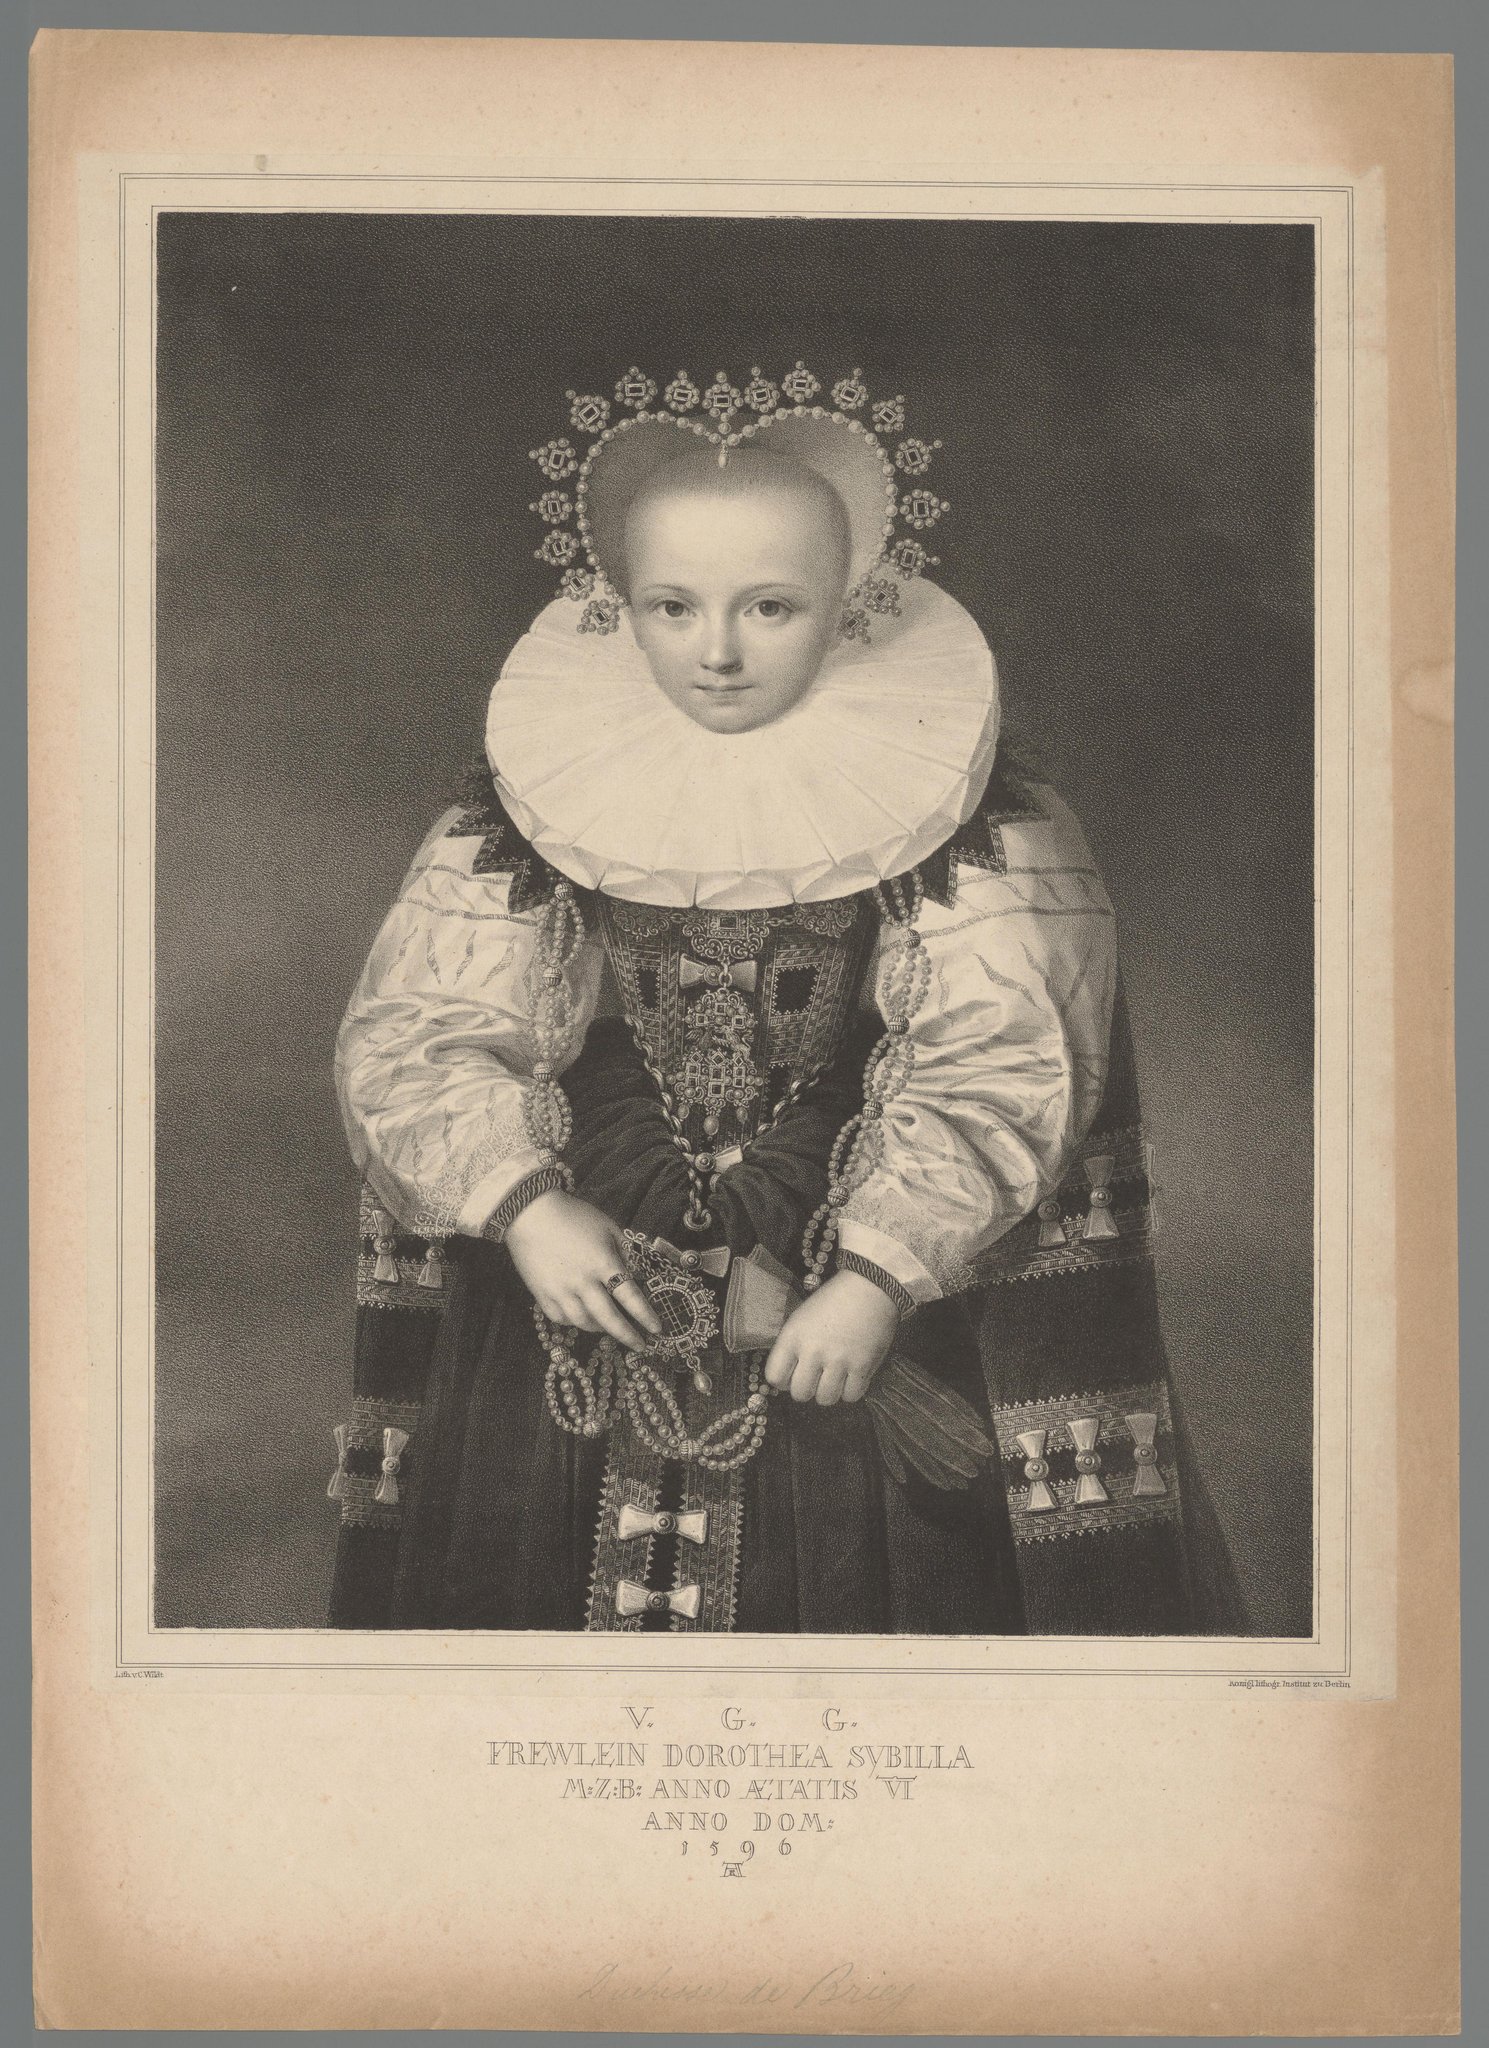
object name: print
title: V.G.G. Frewlein Dorothea Sybilla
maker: carl wildt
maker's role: print maker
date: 1830-1860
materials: paper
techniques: lithograph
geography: berlin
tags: adult man, historical persons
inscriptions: collector's mark: Lugt 2228